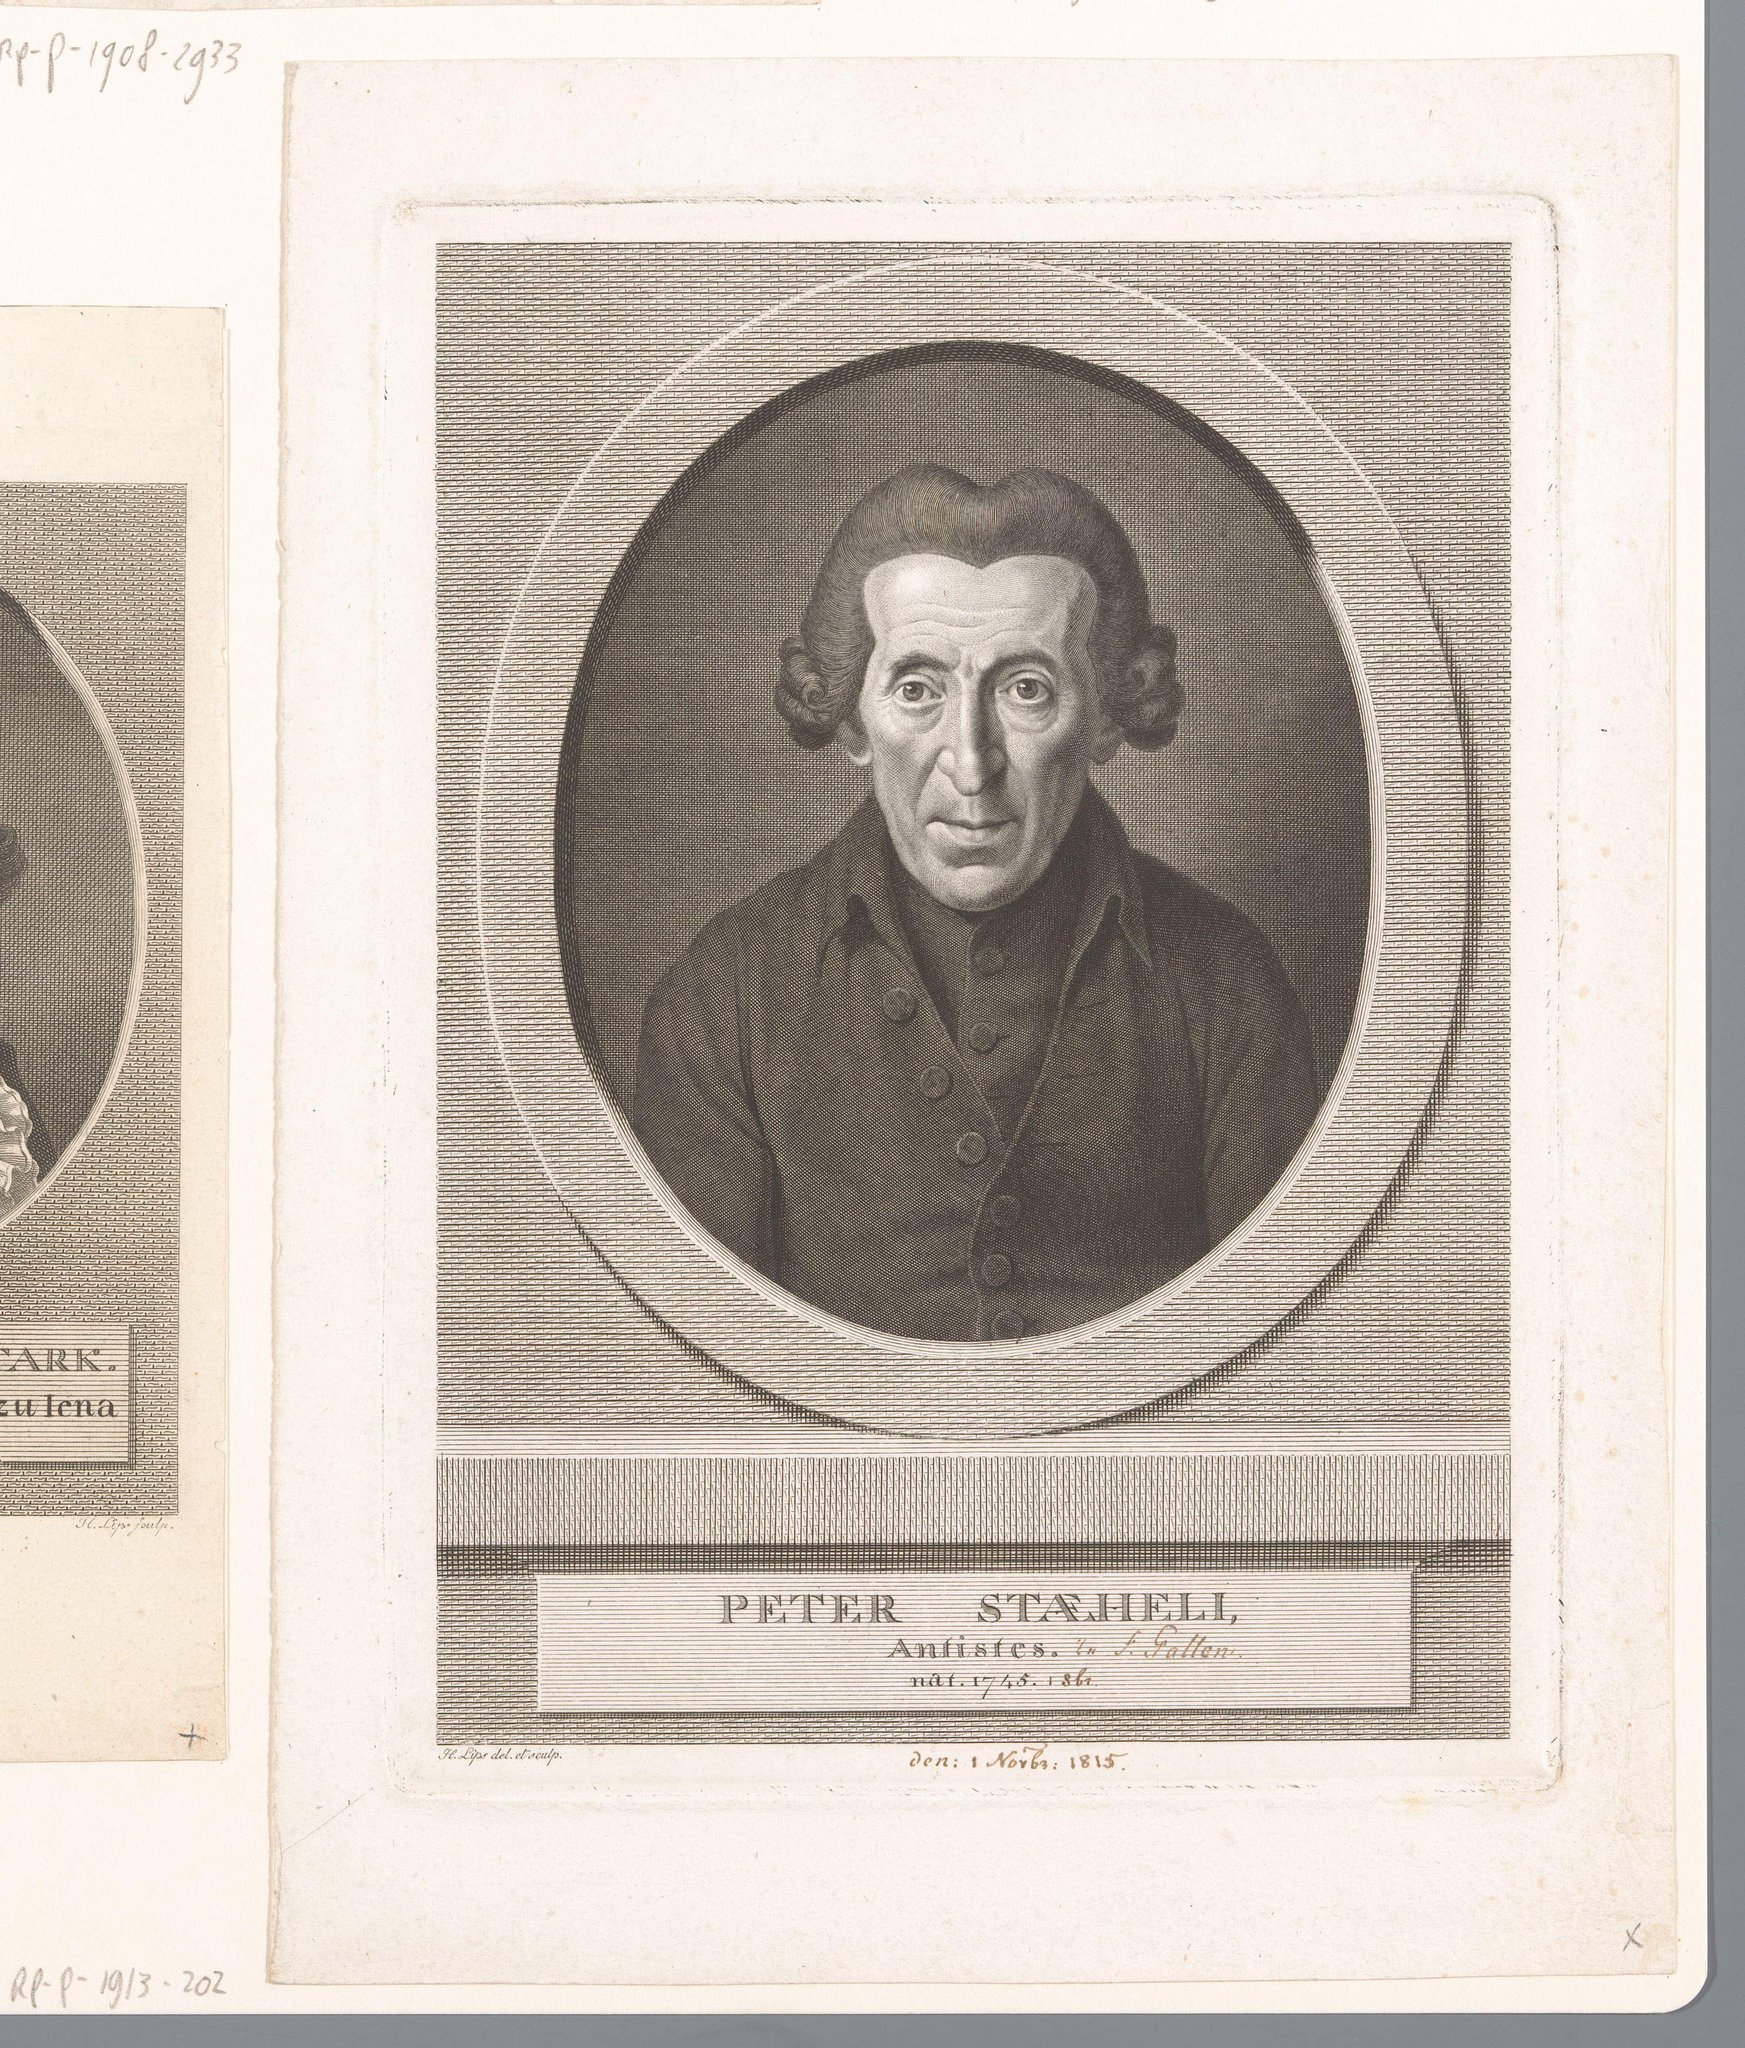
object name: print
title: Portret van Peter Stähelin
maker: johann heinrich lips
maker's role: draughtsman, painter, print maker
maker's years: 1758-1817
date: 1768-1817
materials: paper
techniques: engraving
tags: theologian, historical persons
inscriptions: collector's mark: Lugt 2228